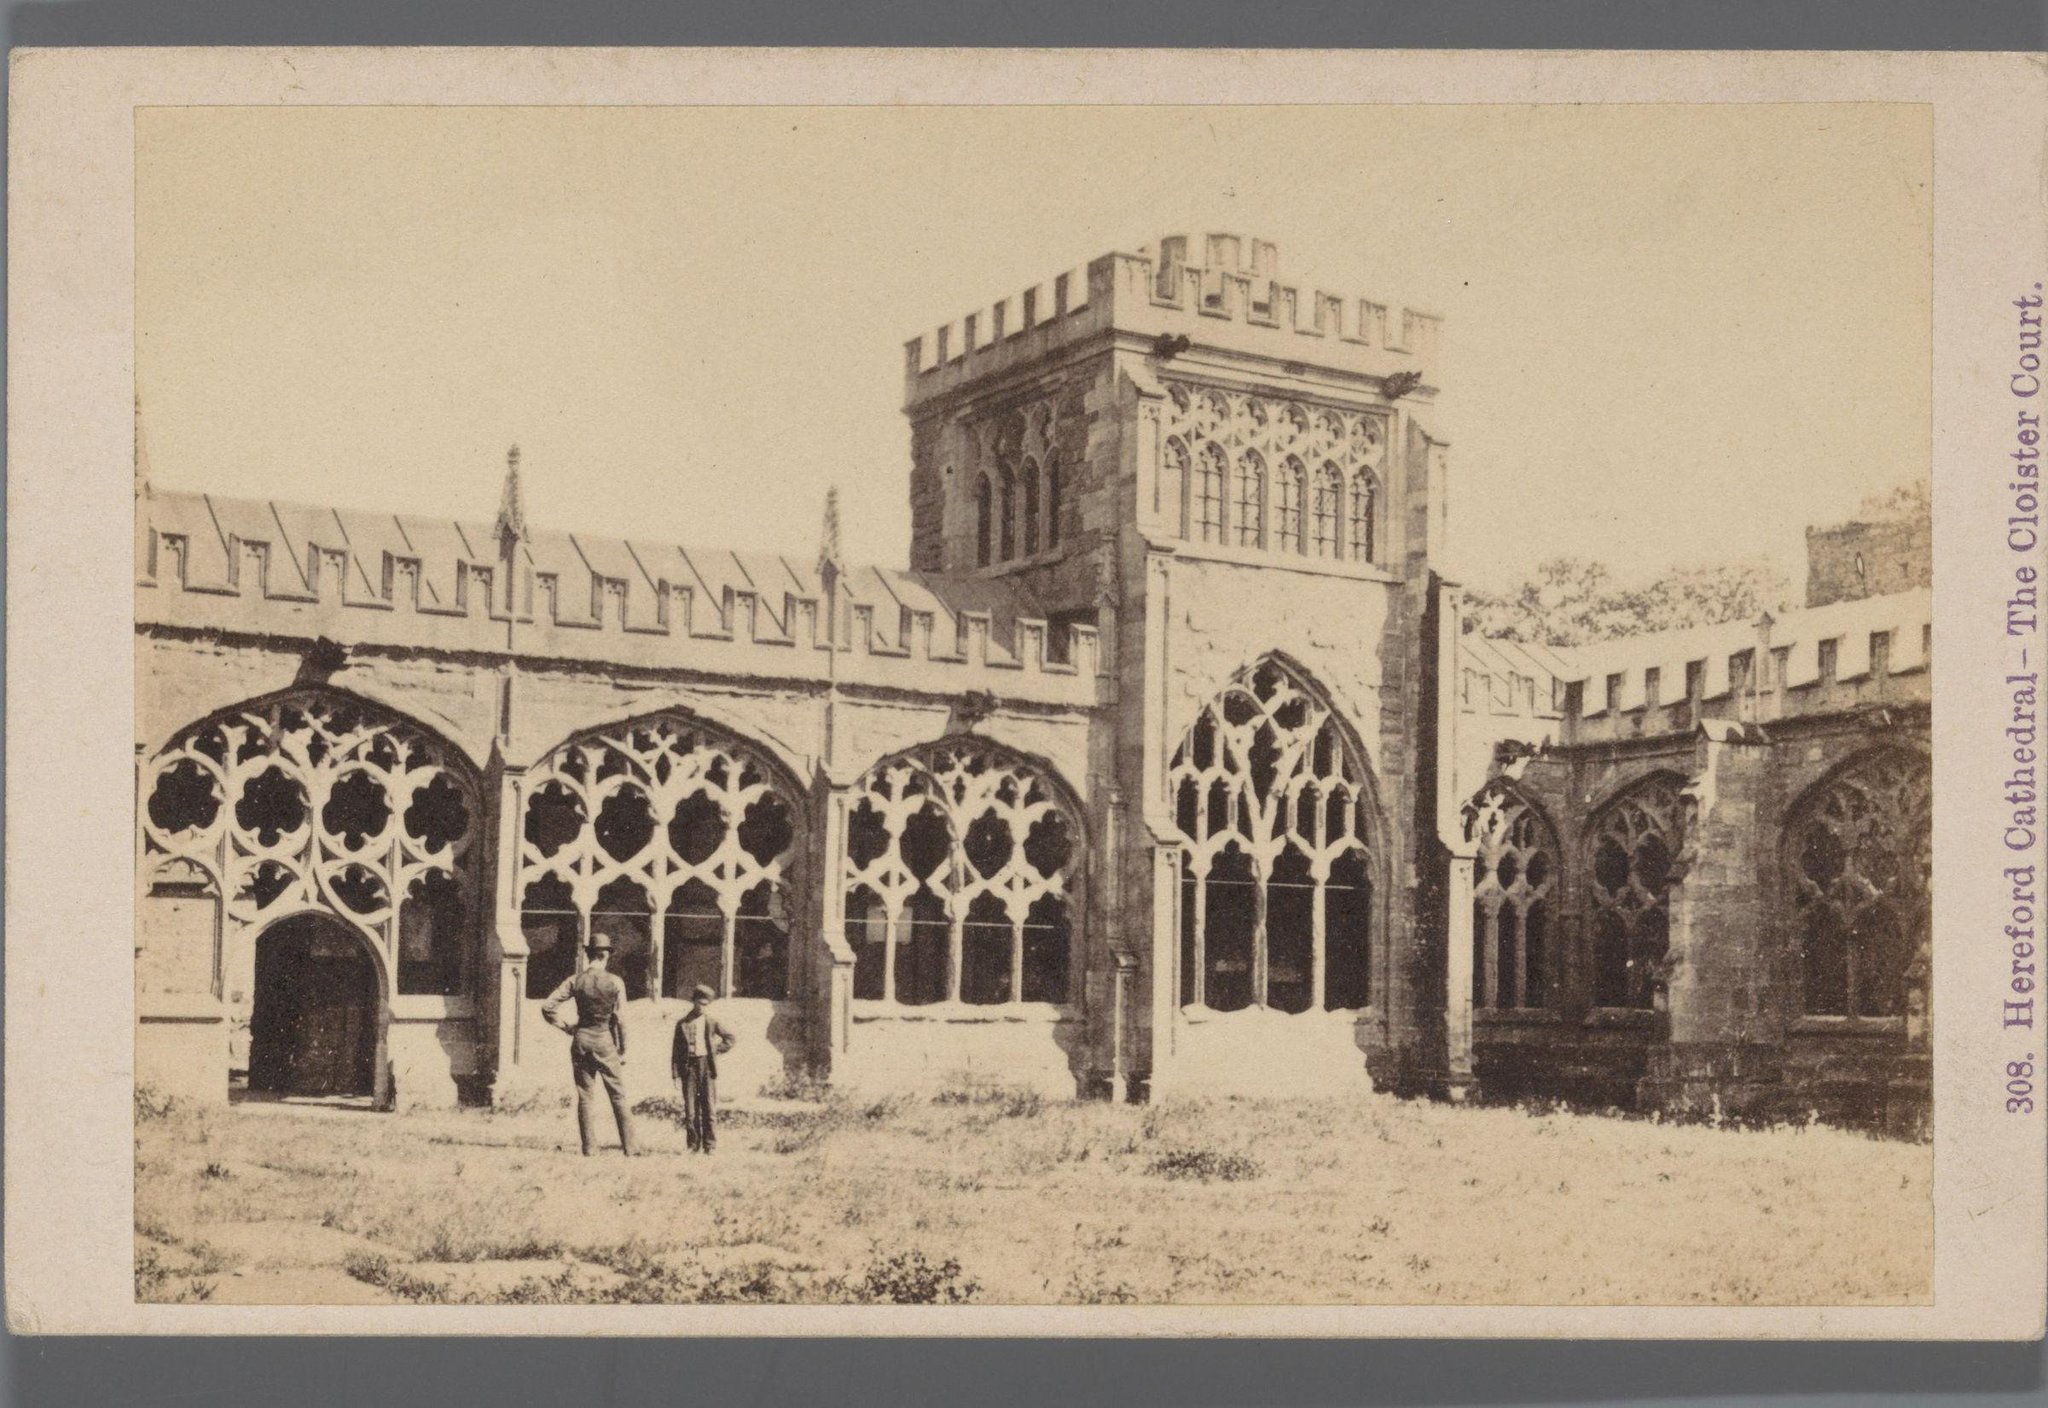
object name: carte de visite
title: Kloostergang van de kathedraal van Hereford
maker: francis bedford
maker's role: print maker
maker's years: 1815-1894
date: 1856-1894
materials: cardboard, paper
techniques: albumen print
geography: hereford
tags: church (exterior), cloisters ~ monastery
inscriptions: number: ‘308.’, inscription: ‘PHOTOGRAPHED BY/ F. BEDFORD/ PHOTOGRAPHER TO/ H.R.H./ THE PRINCE OF WALES.’